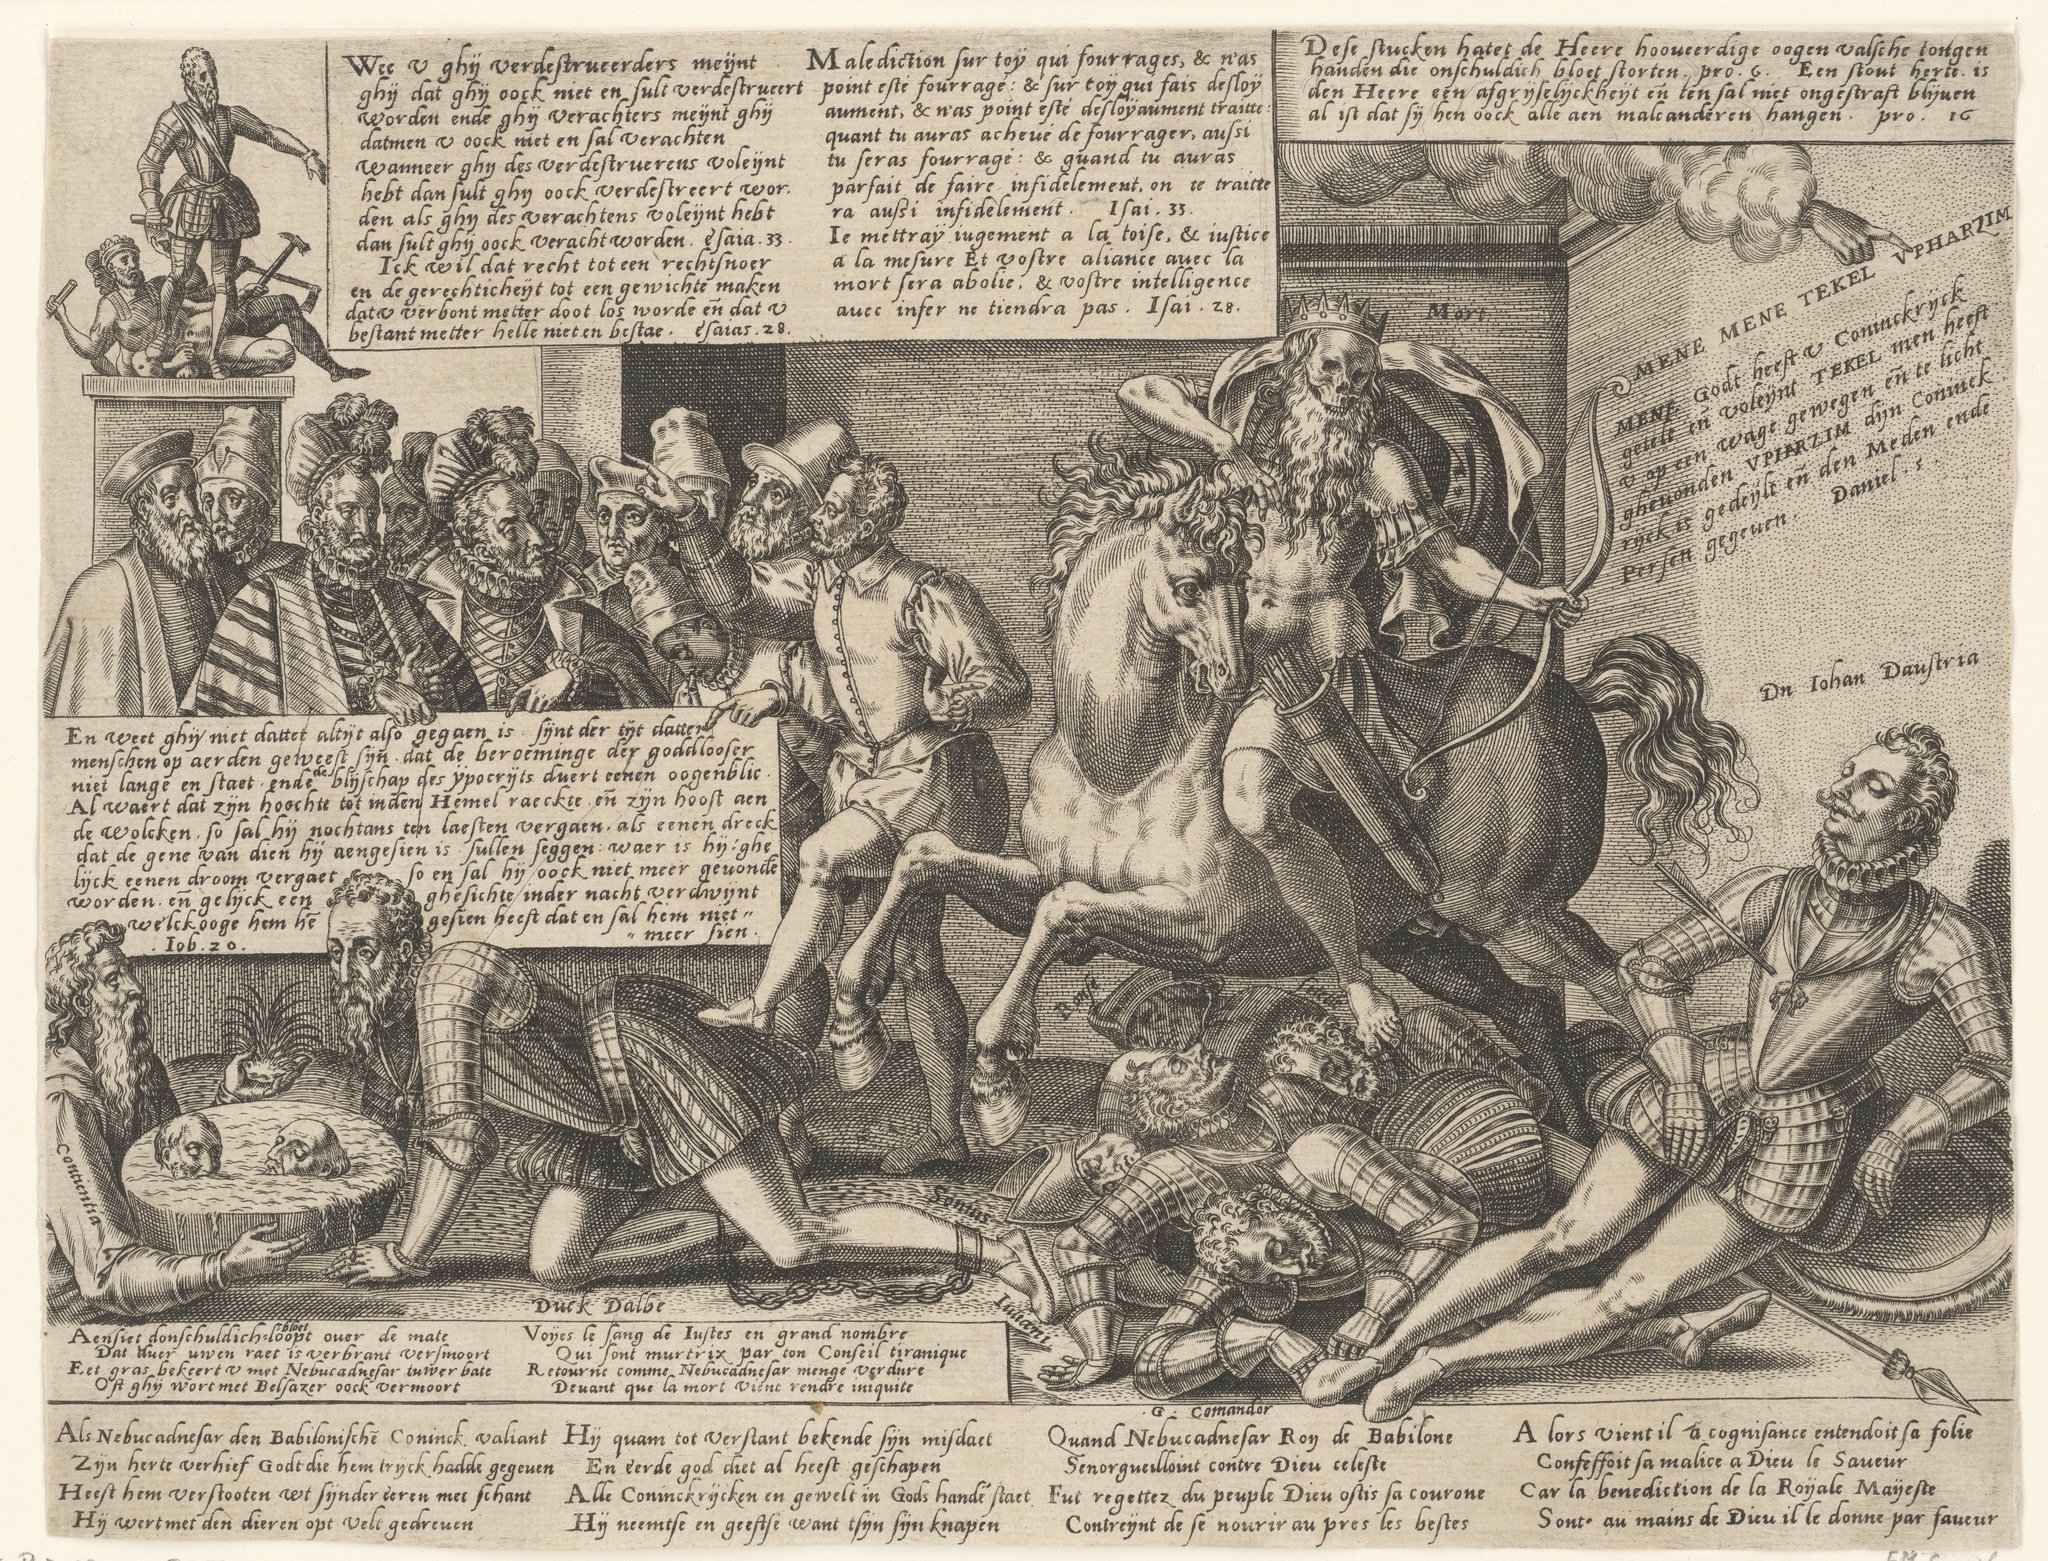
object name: print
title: De dood van Don Juan en de vernedering van Alva, 1578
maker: Anonymous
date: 1578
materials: paper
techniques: engraving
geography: northern netherlands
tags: fernando álvarez de toledo (3rd duke of alba), luis de zúñiga y requesens, don juan van oostenrijk, brussels, earl, personifications of death; 'morte' (ripa), piece of sculpture, reproduction of a piece of sculpture, during belshazzar's banquet a hand appears and writes on the wall (mene, mene, tekel and parsin (upharsin)); king belshazzar is frightened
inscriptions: collector's mark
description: De dood van Don Juan en de vernedering van Alva, 1578. Politieke allegorie waarin Don Juan door de Dood te paard met een pijl doorschoten wordt. Linksvoor kruipt de hertog van Alva geketend over de grond gelijk Nebukadnezar. Rechts schrijft de hand van God woorden op de muur. Op de grond een stapel lichamen van eerder in de strijd gestorven Spanjaarden, links kijkt een groep staande figuren, waaronder Egmond en Horne, toe. Op de achtergrond het standbeeld van Alva uit de Citadel van Antwerpen. Met opschriften en bijbelteksten in de voorstelling het Nederlands en Frans, met onderschrift van 4 verzen van 4 regels in het Nederlands en Frans.